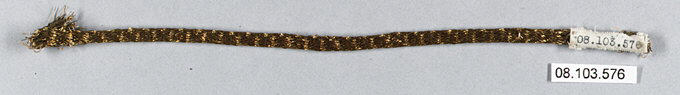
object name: cord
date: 1801-1900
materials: metal thread